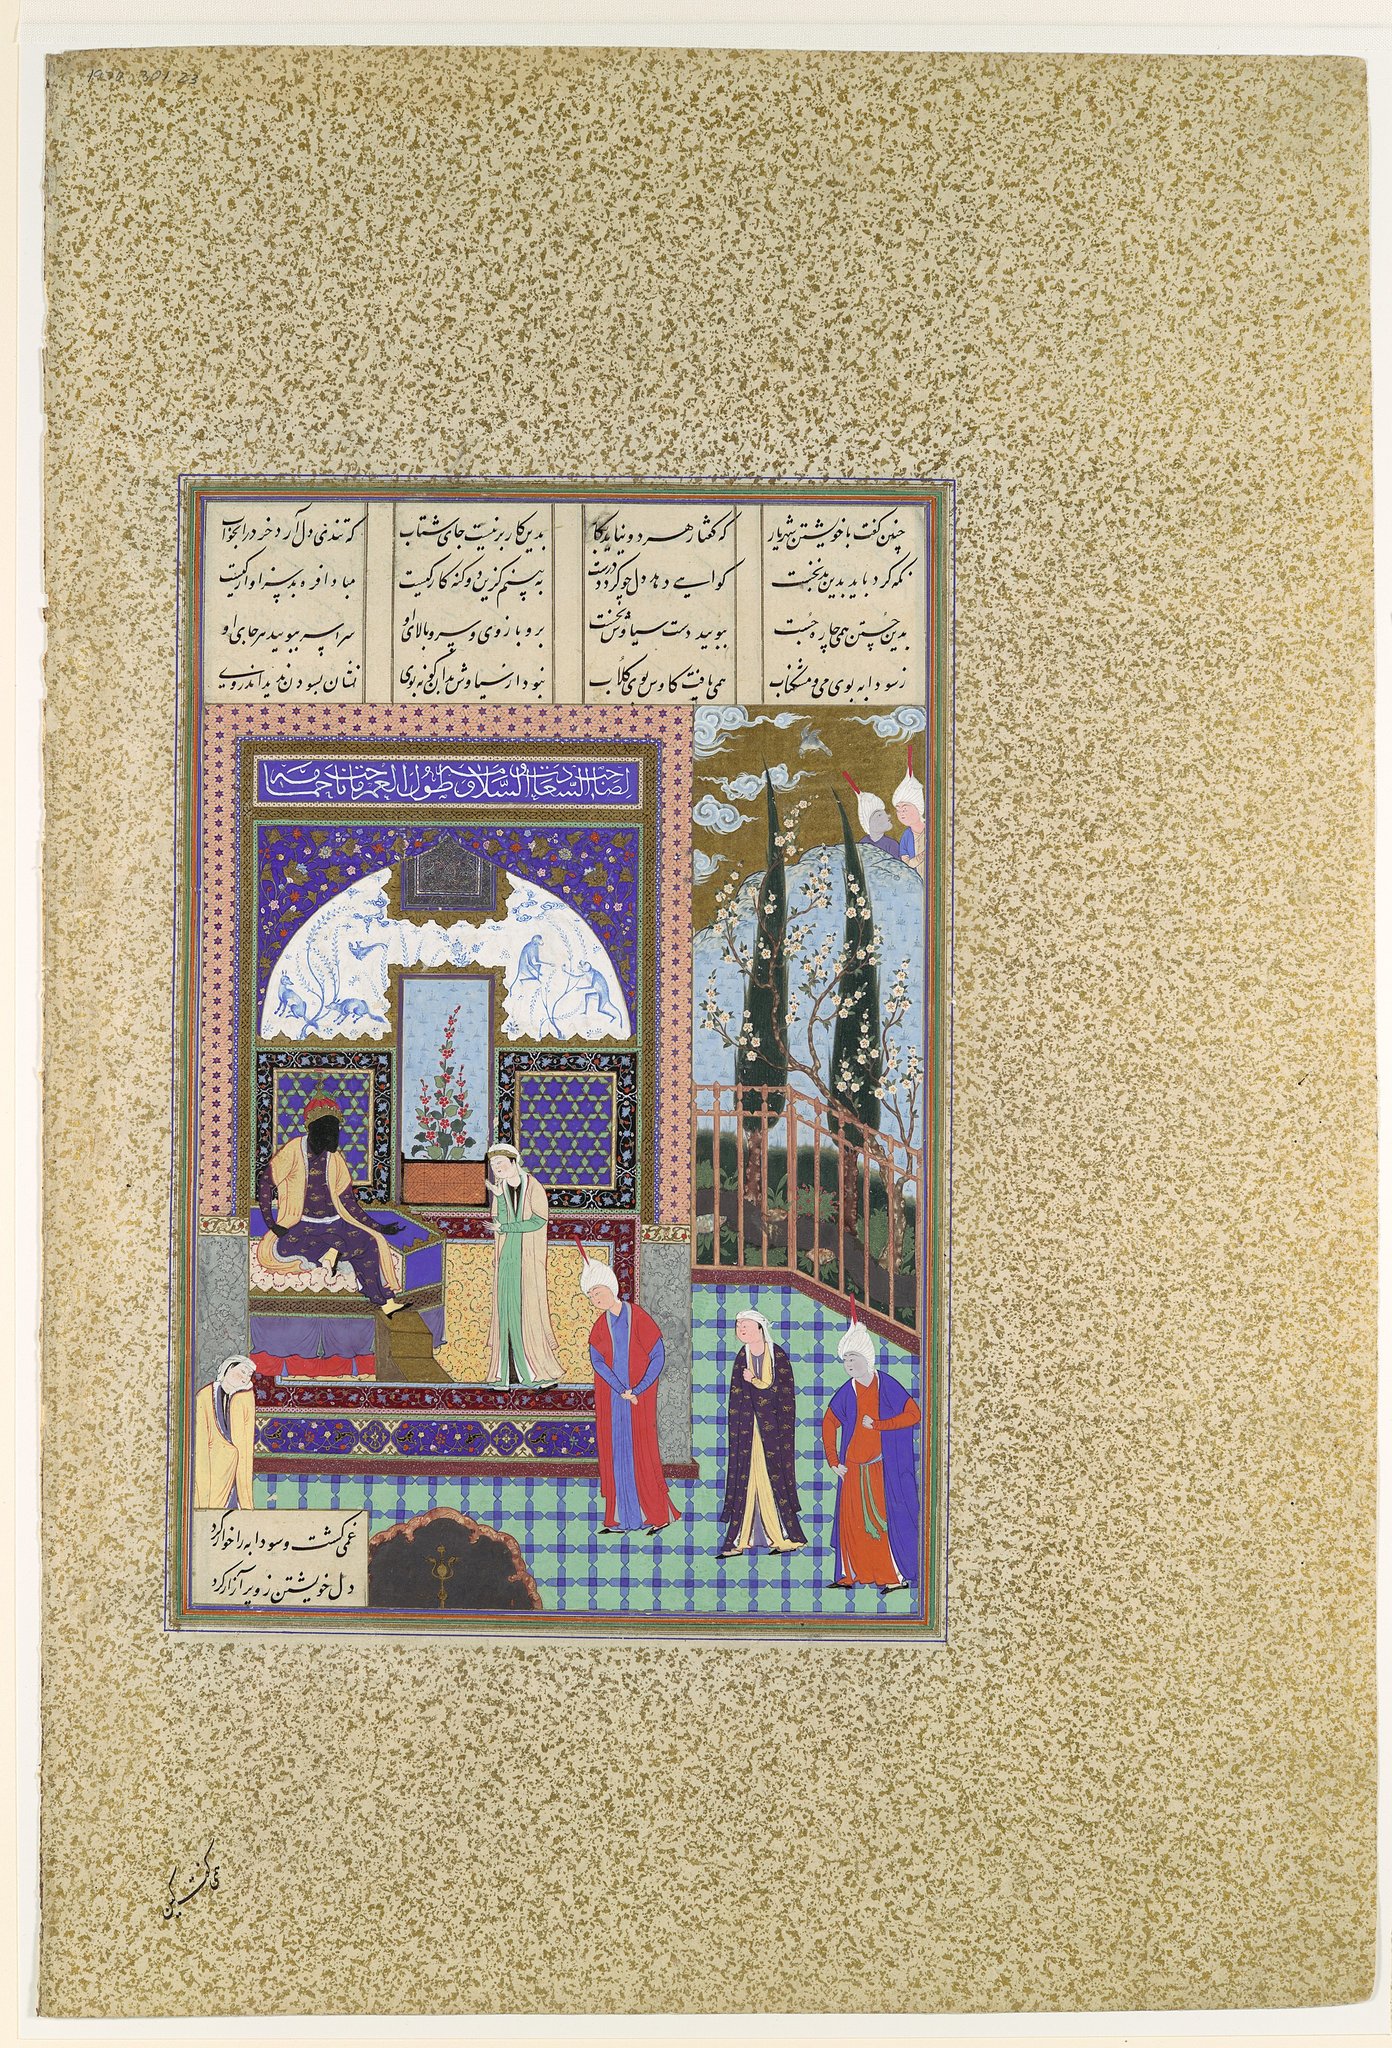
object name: folio from an illustrated manuscript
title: "Siyavush Stands Accused by Sudaba before Kai Kavus", Folio 163v from the Shahnama (Book of Kings) of Shah Tahmasp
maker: abu'l qasim firdausi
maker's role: author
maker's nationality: iranian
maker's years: 935-1020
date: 1530-1535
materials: gold, ink, paper, silver, watercolor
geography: iran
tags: poetry,men,women